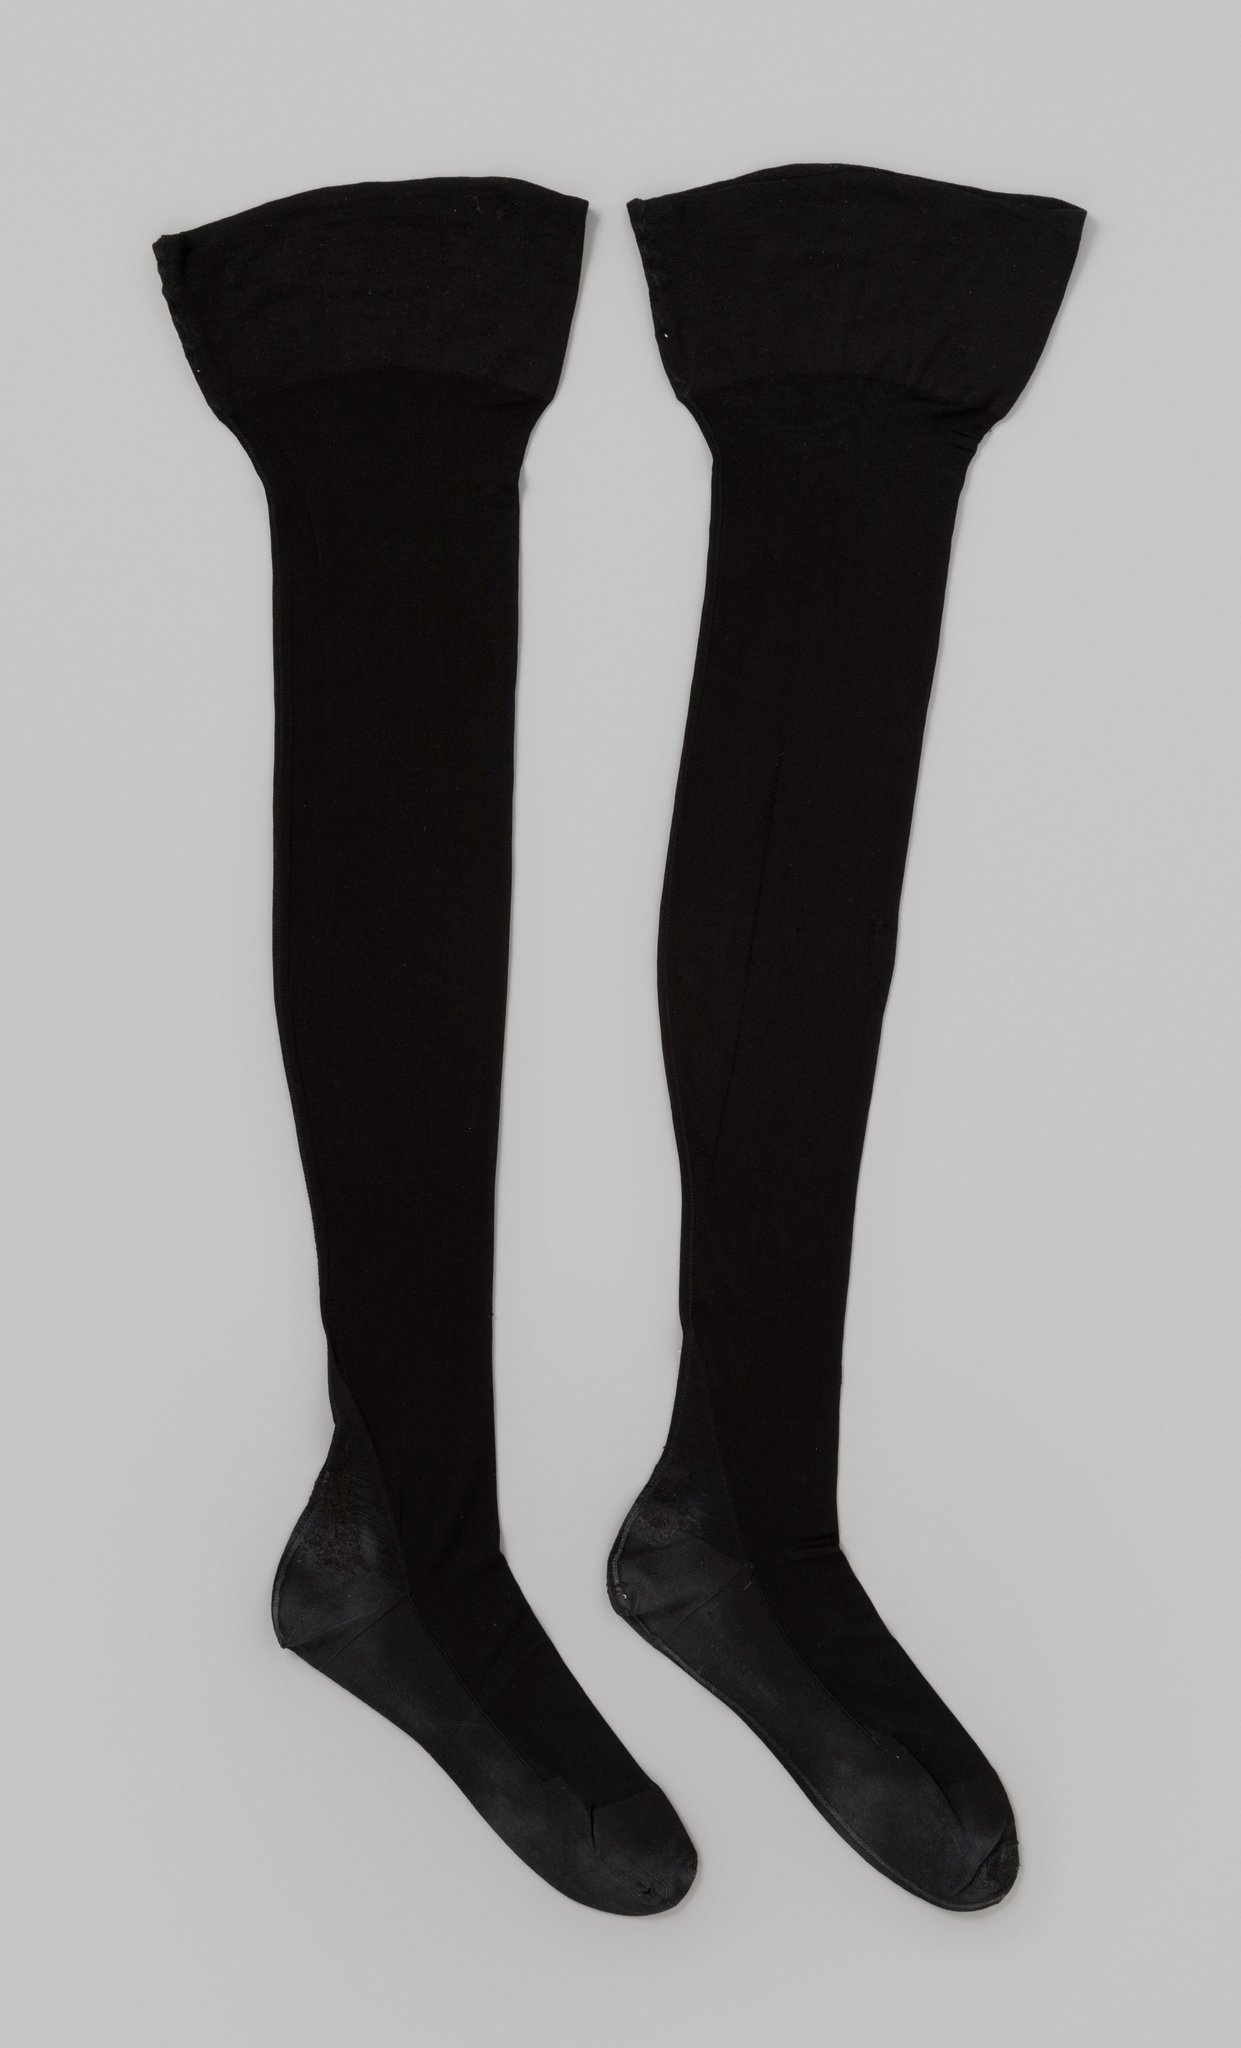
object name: stocking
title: Kous van effen zwarte zijde met voet en boord van katoen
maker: Anonymous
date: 1915-1935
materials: cotton, silk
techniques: knitting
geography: netherlands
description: Vijf paar zwarte kousen van zijde. Alle verschillend, alle van dikke tricot. Alle met naad en hiel. Brede verschillende boorden; enkele van katoen. Eén paar heeft een enkel-pijl, de klink.